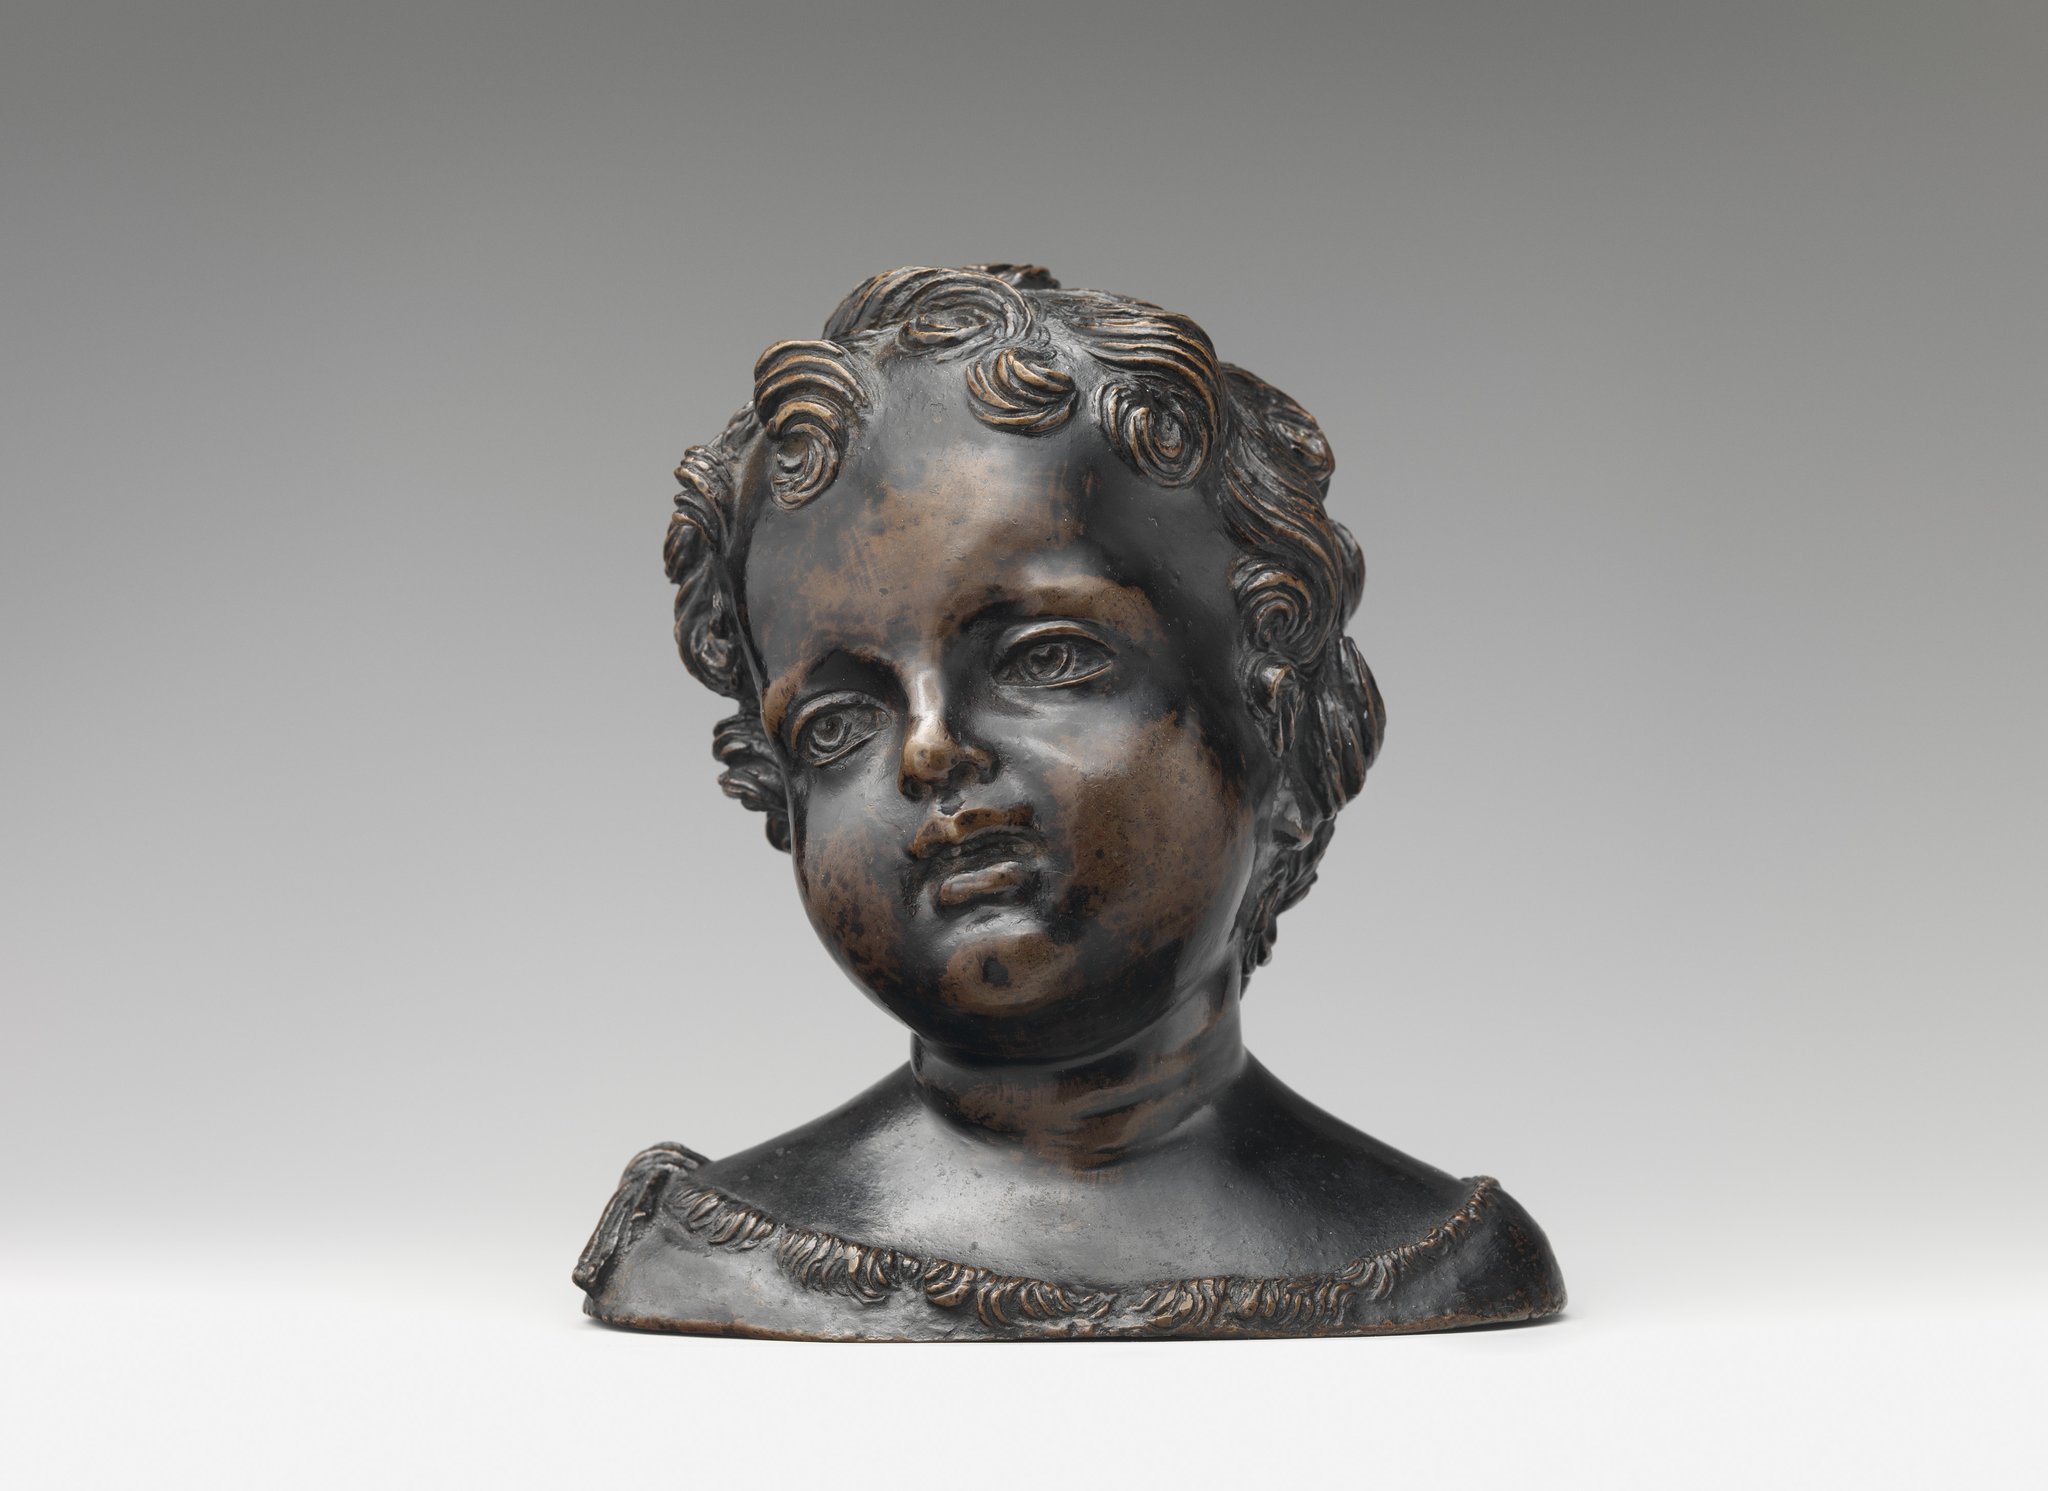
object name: bust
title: Young St. John the Baptist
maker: antonio lombardo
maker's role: artist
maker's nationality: italian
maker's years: 1453-1516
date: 1501-1533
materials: bronze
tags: boys,saint john the baptist